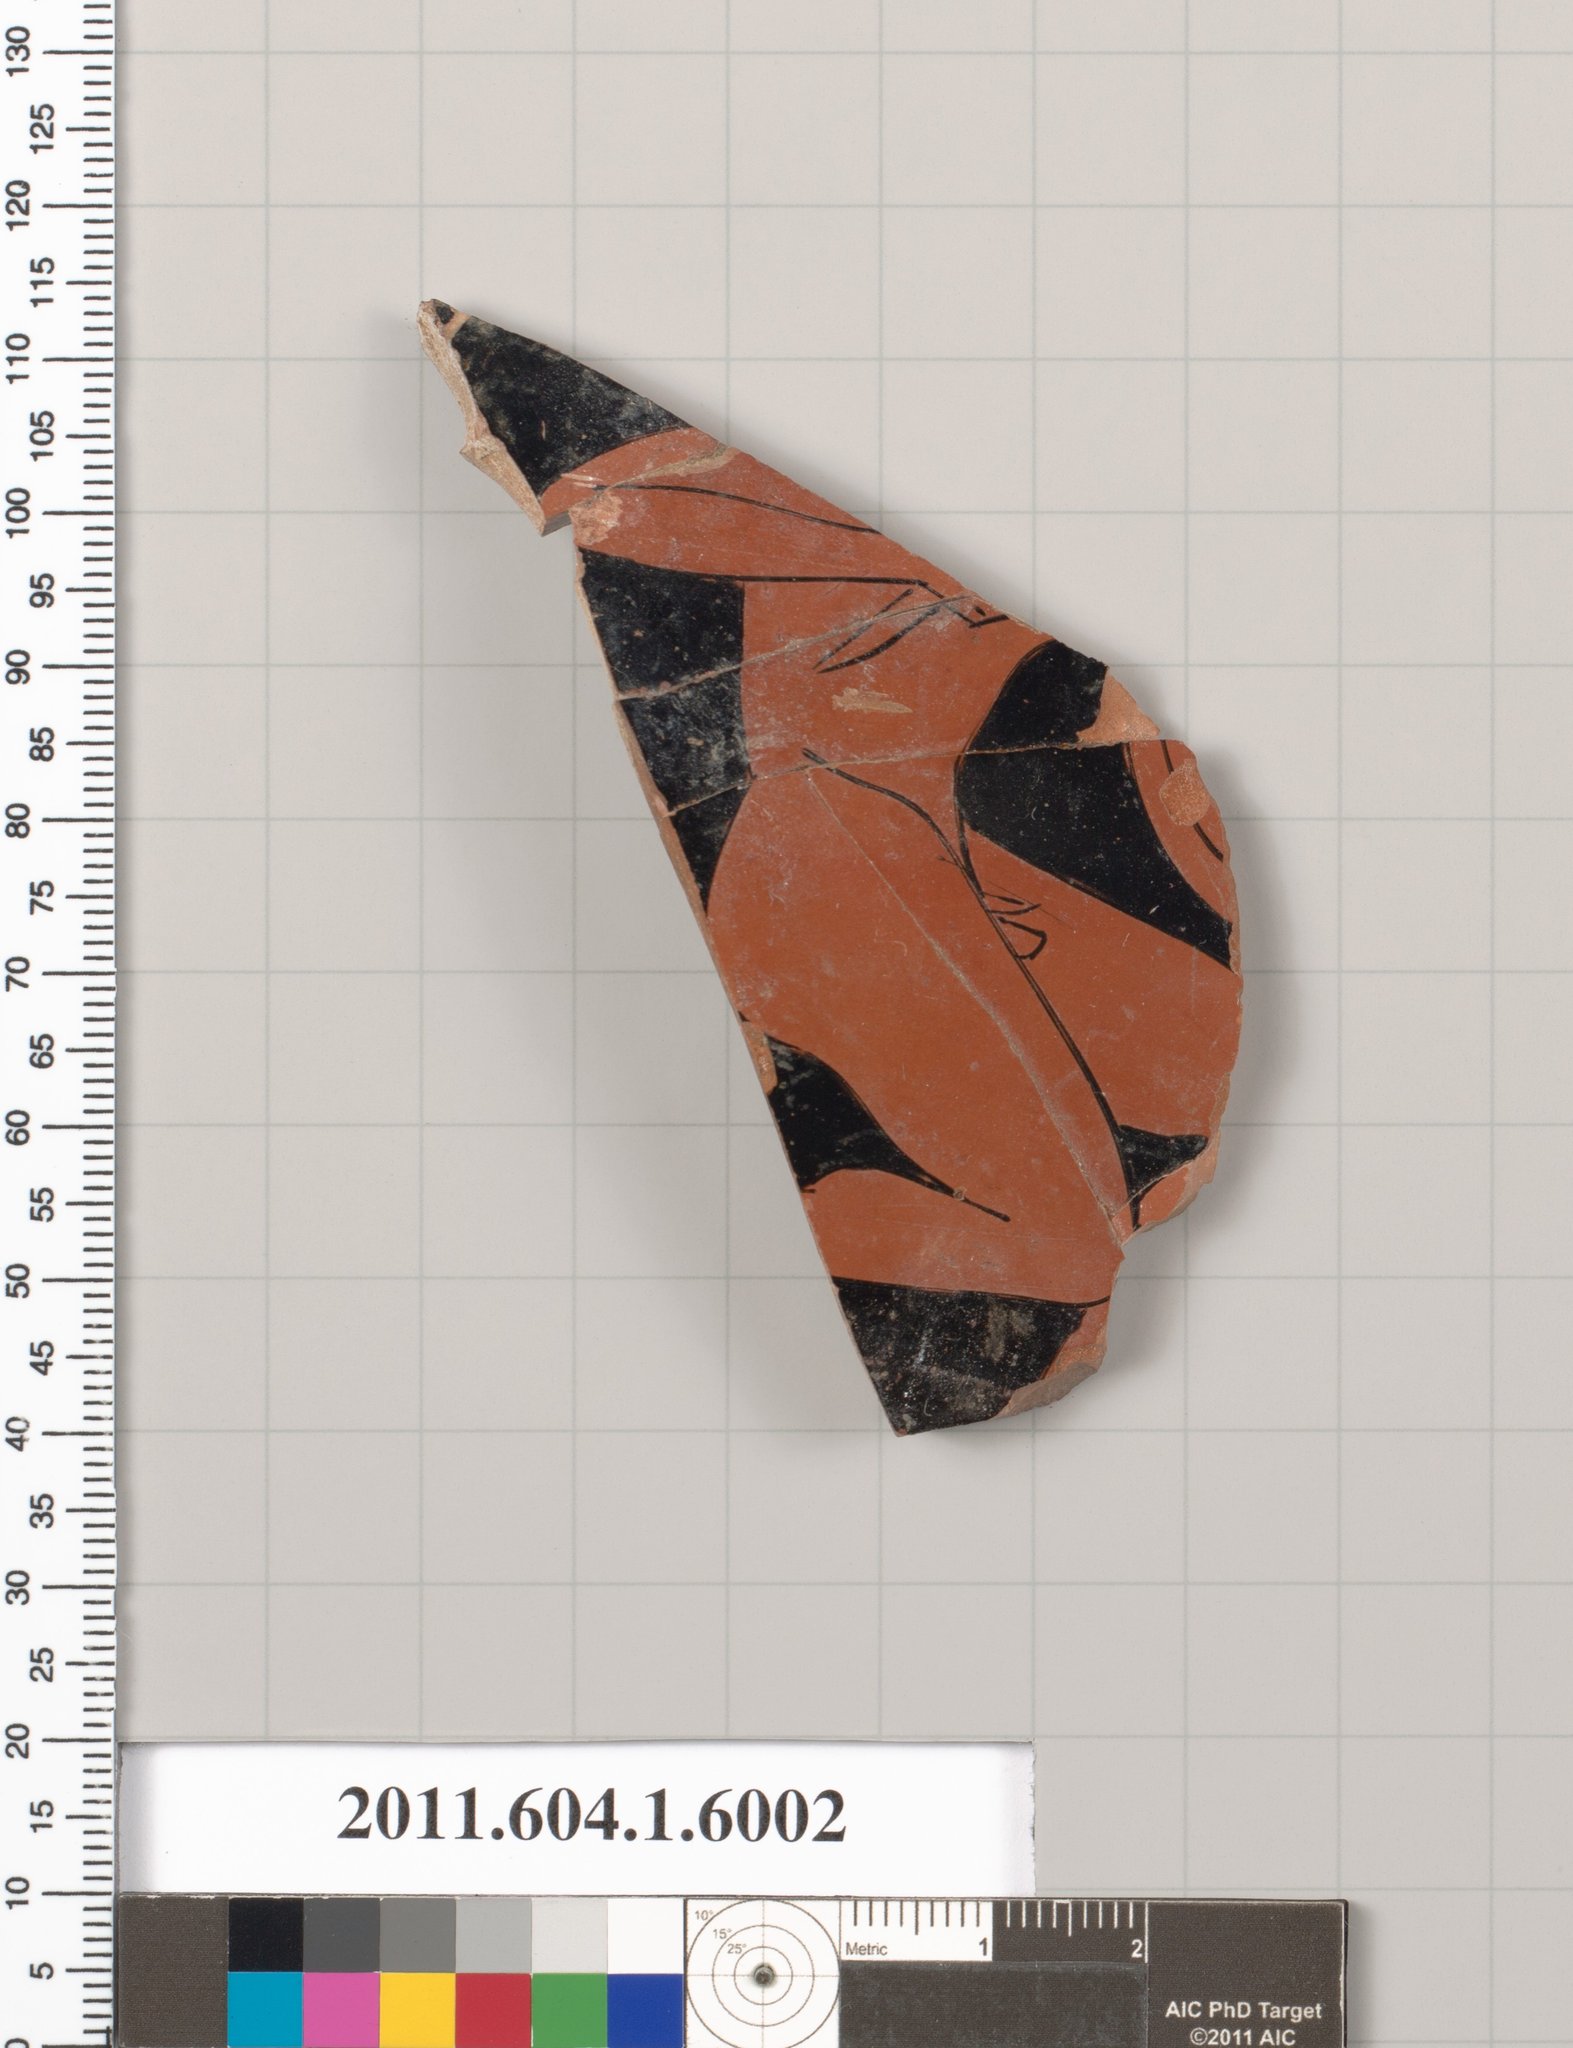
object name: kylix fragment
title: Terracotta fragment of a kylix (drinking cup)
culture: greek, attic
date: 510-500 BCE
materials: terracotta